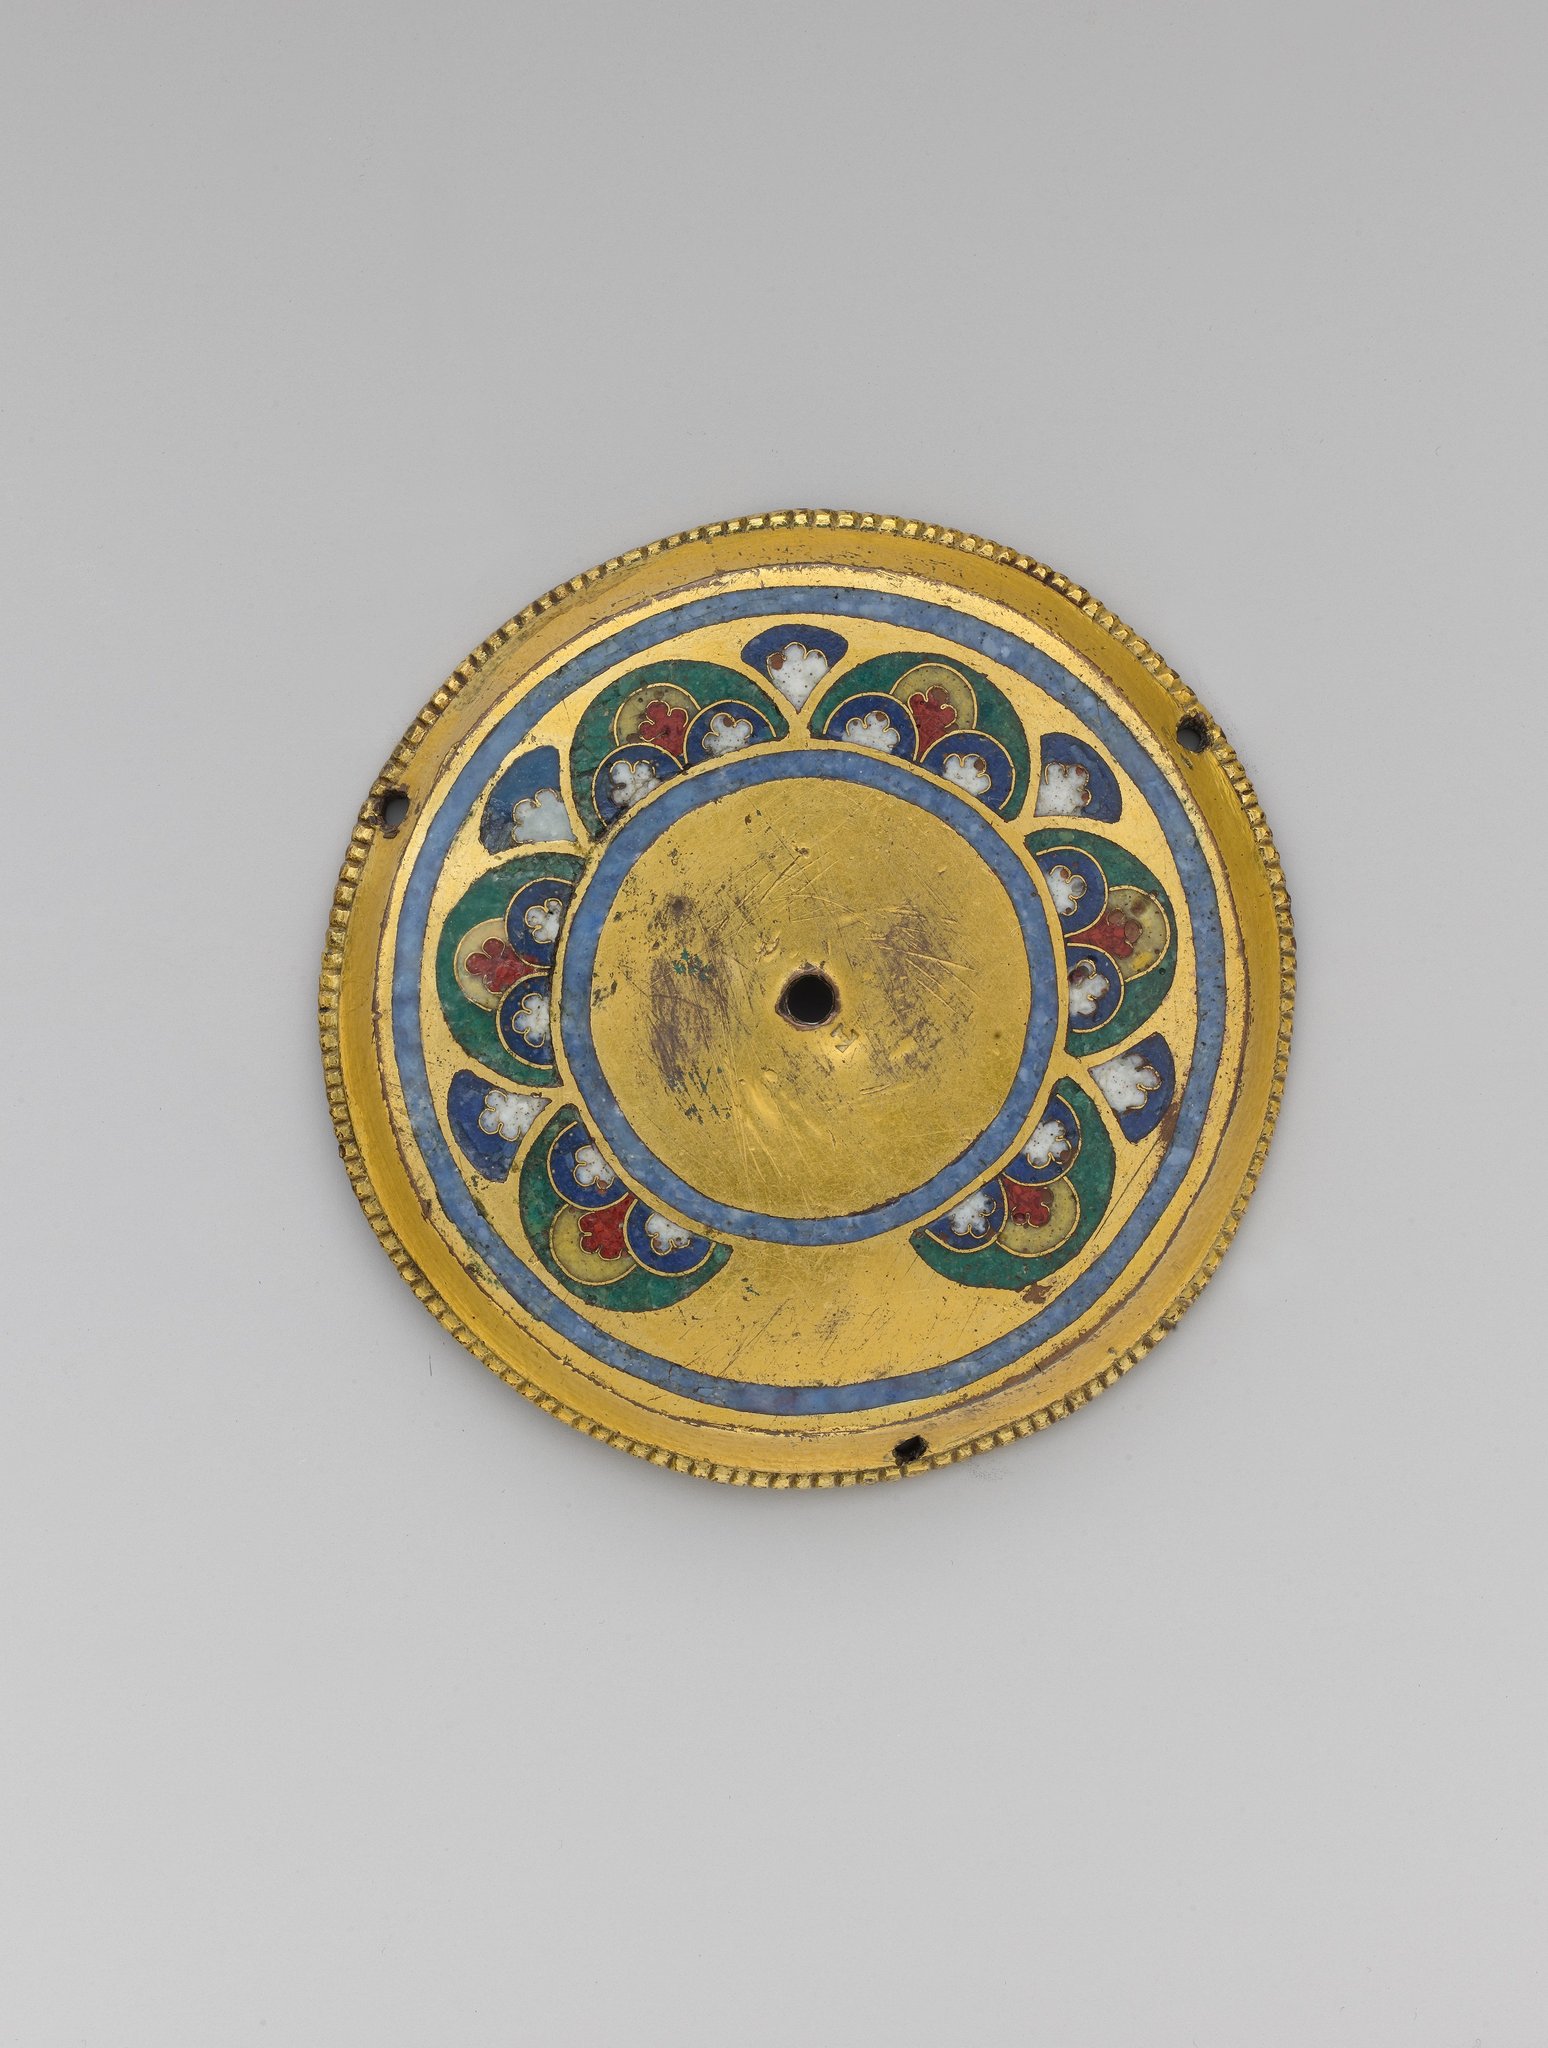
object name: halo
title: Enamel from a Reliquary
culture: german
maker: master of the virgin mary's reliquary casket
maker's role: artist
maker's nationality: german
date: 1201-1233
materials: gilt copper, enamel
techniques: enamel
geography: germany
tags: reliquaries